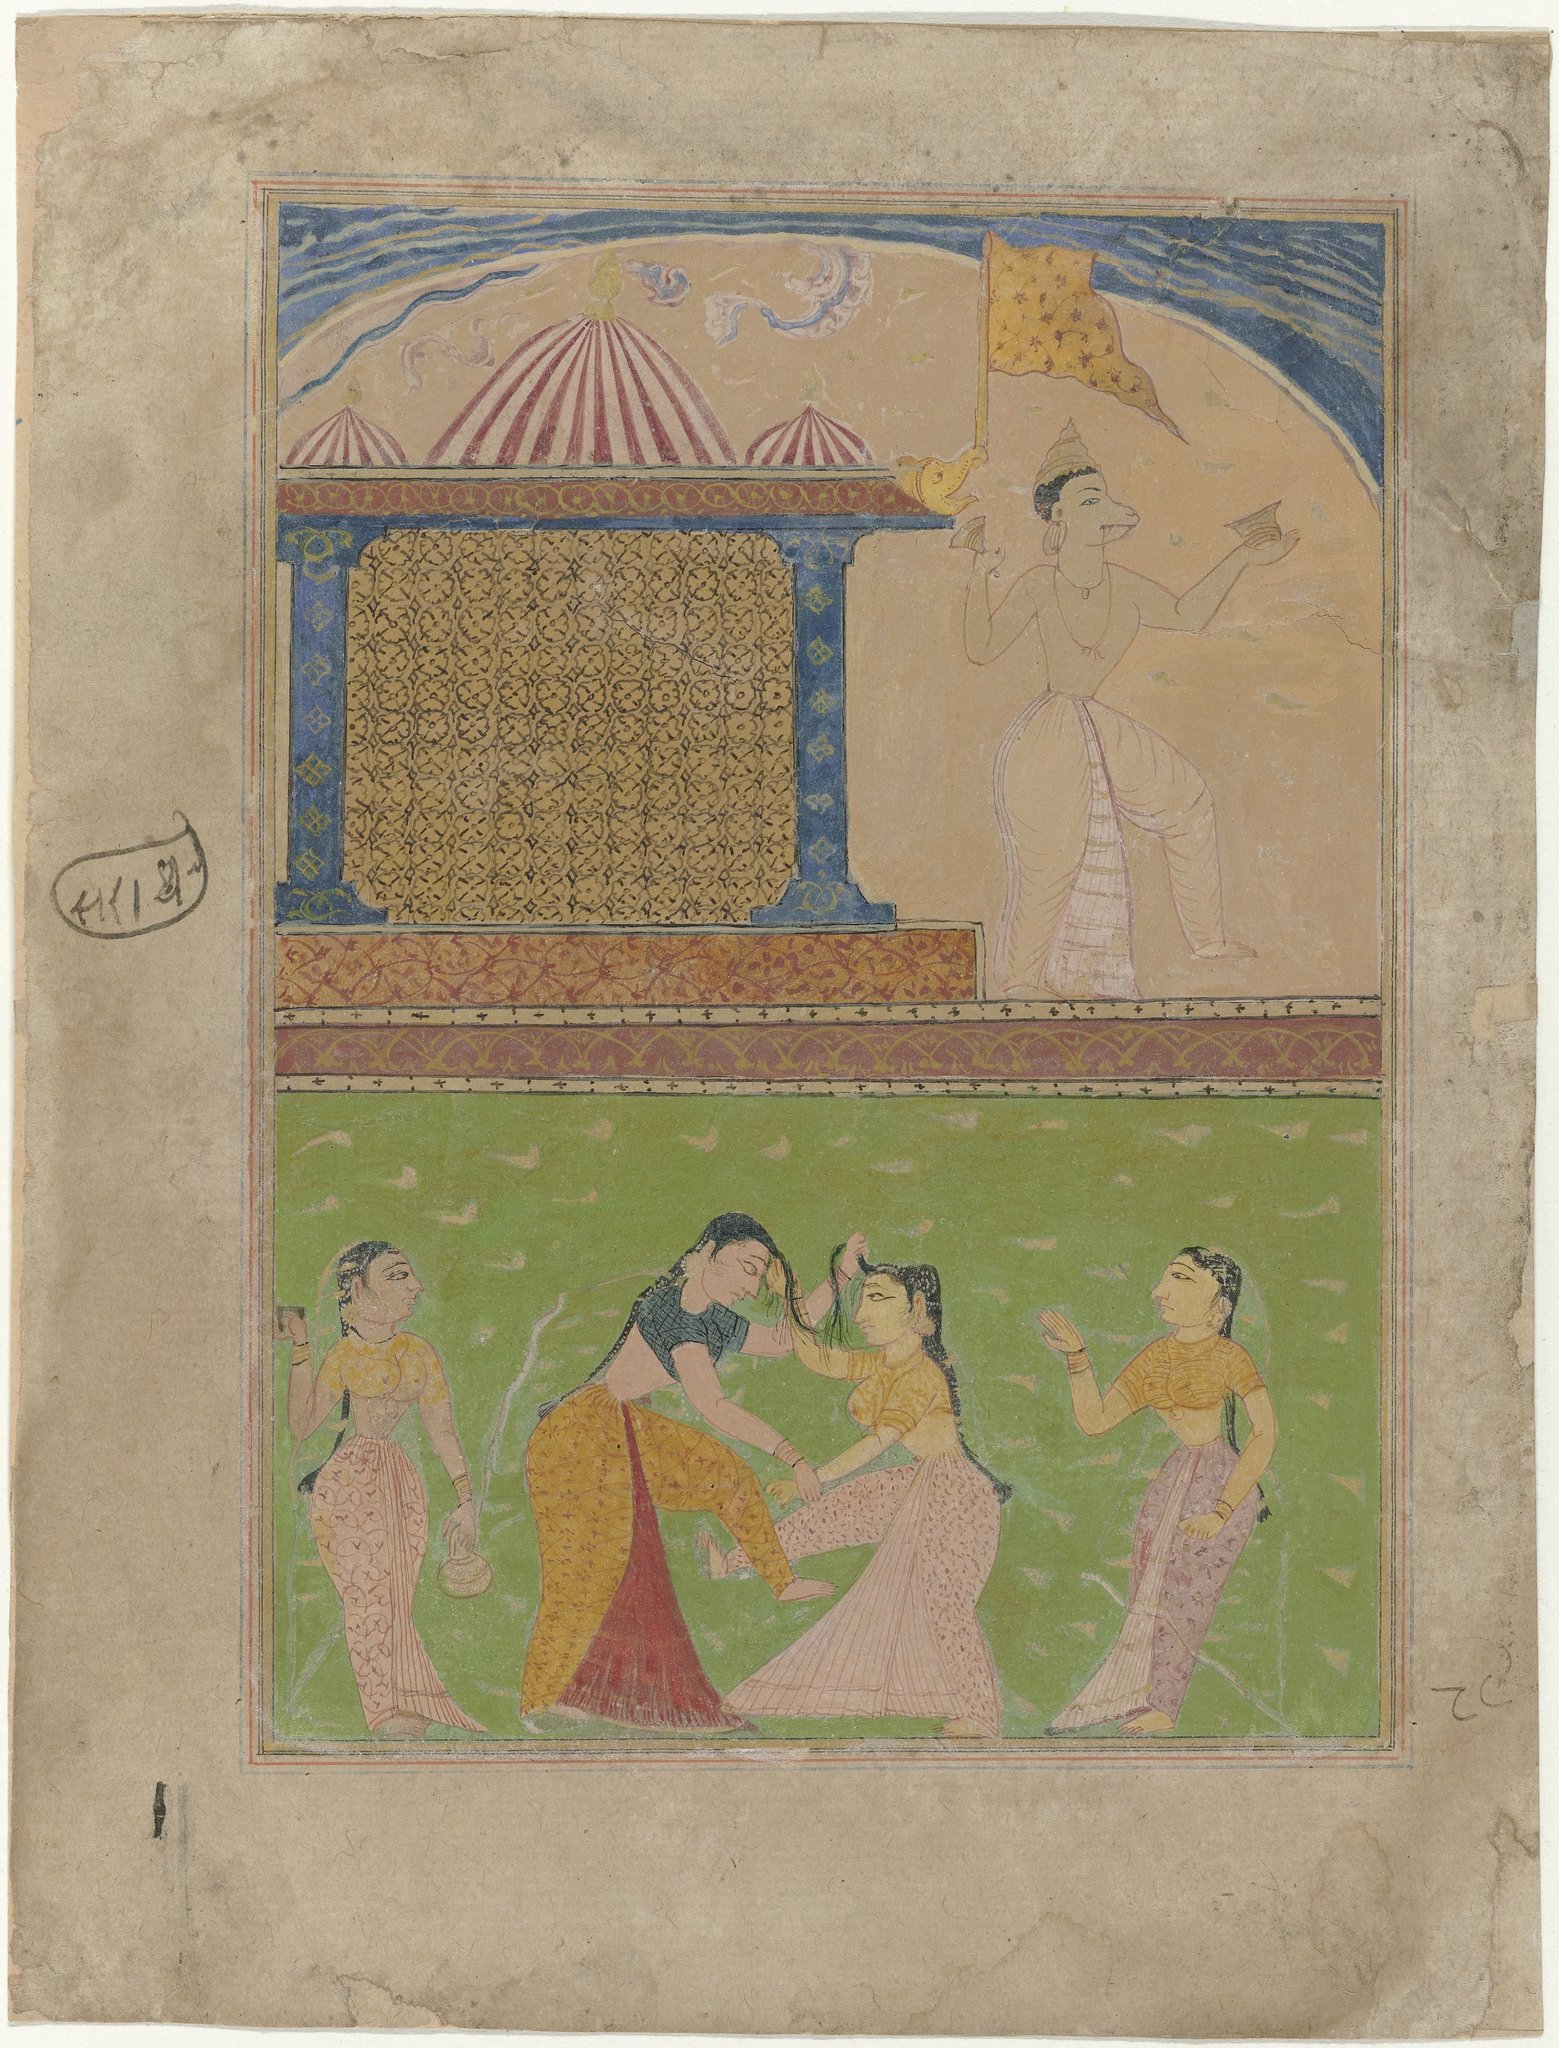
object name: indian miniature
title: Gevecht tussen Maina en Chanda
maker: Anonymous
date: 1640-1660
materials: paper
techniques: brush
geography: malwa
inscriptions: inscription